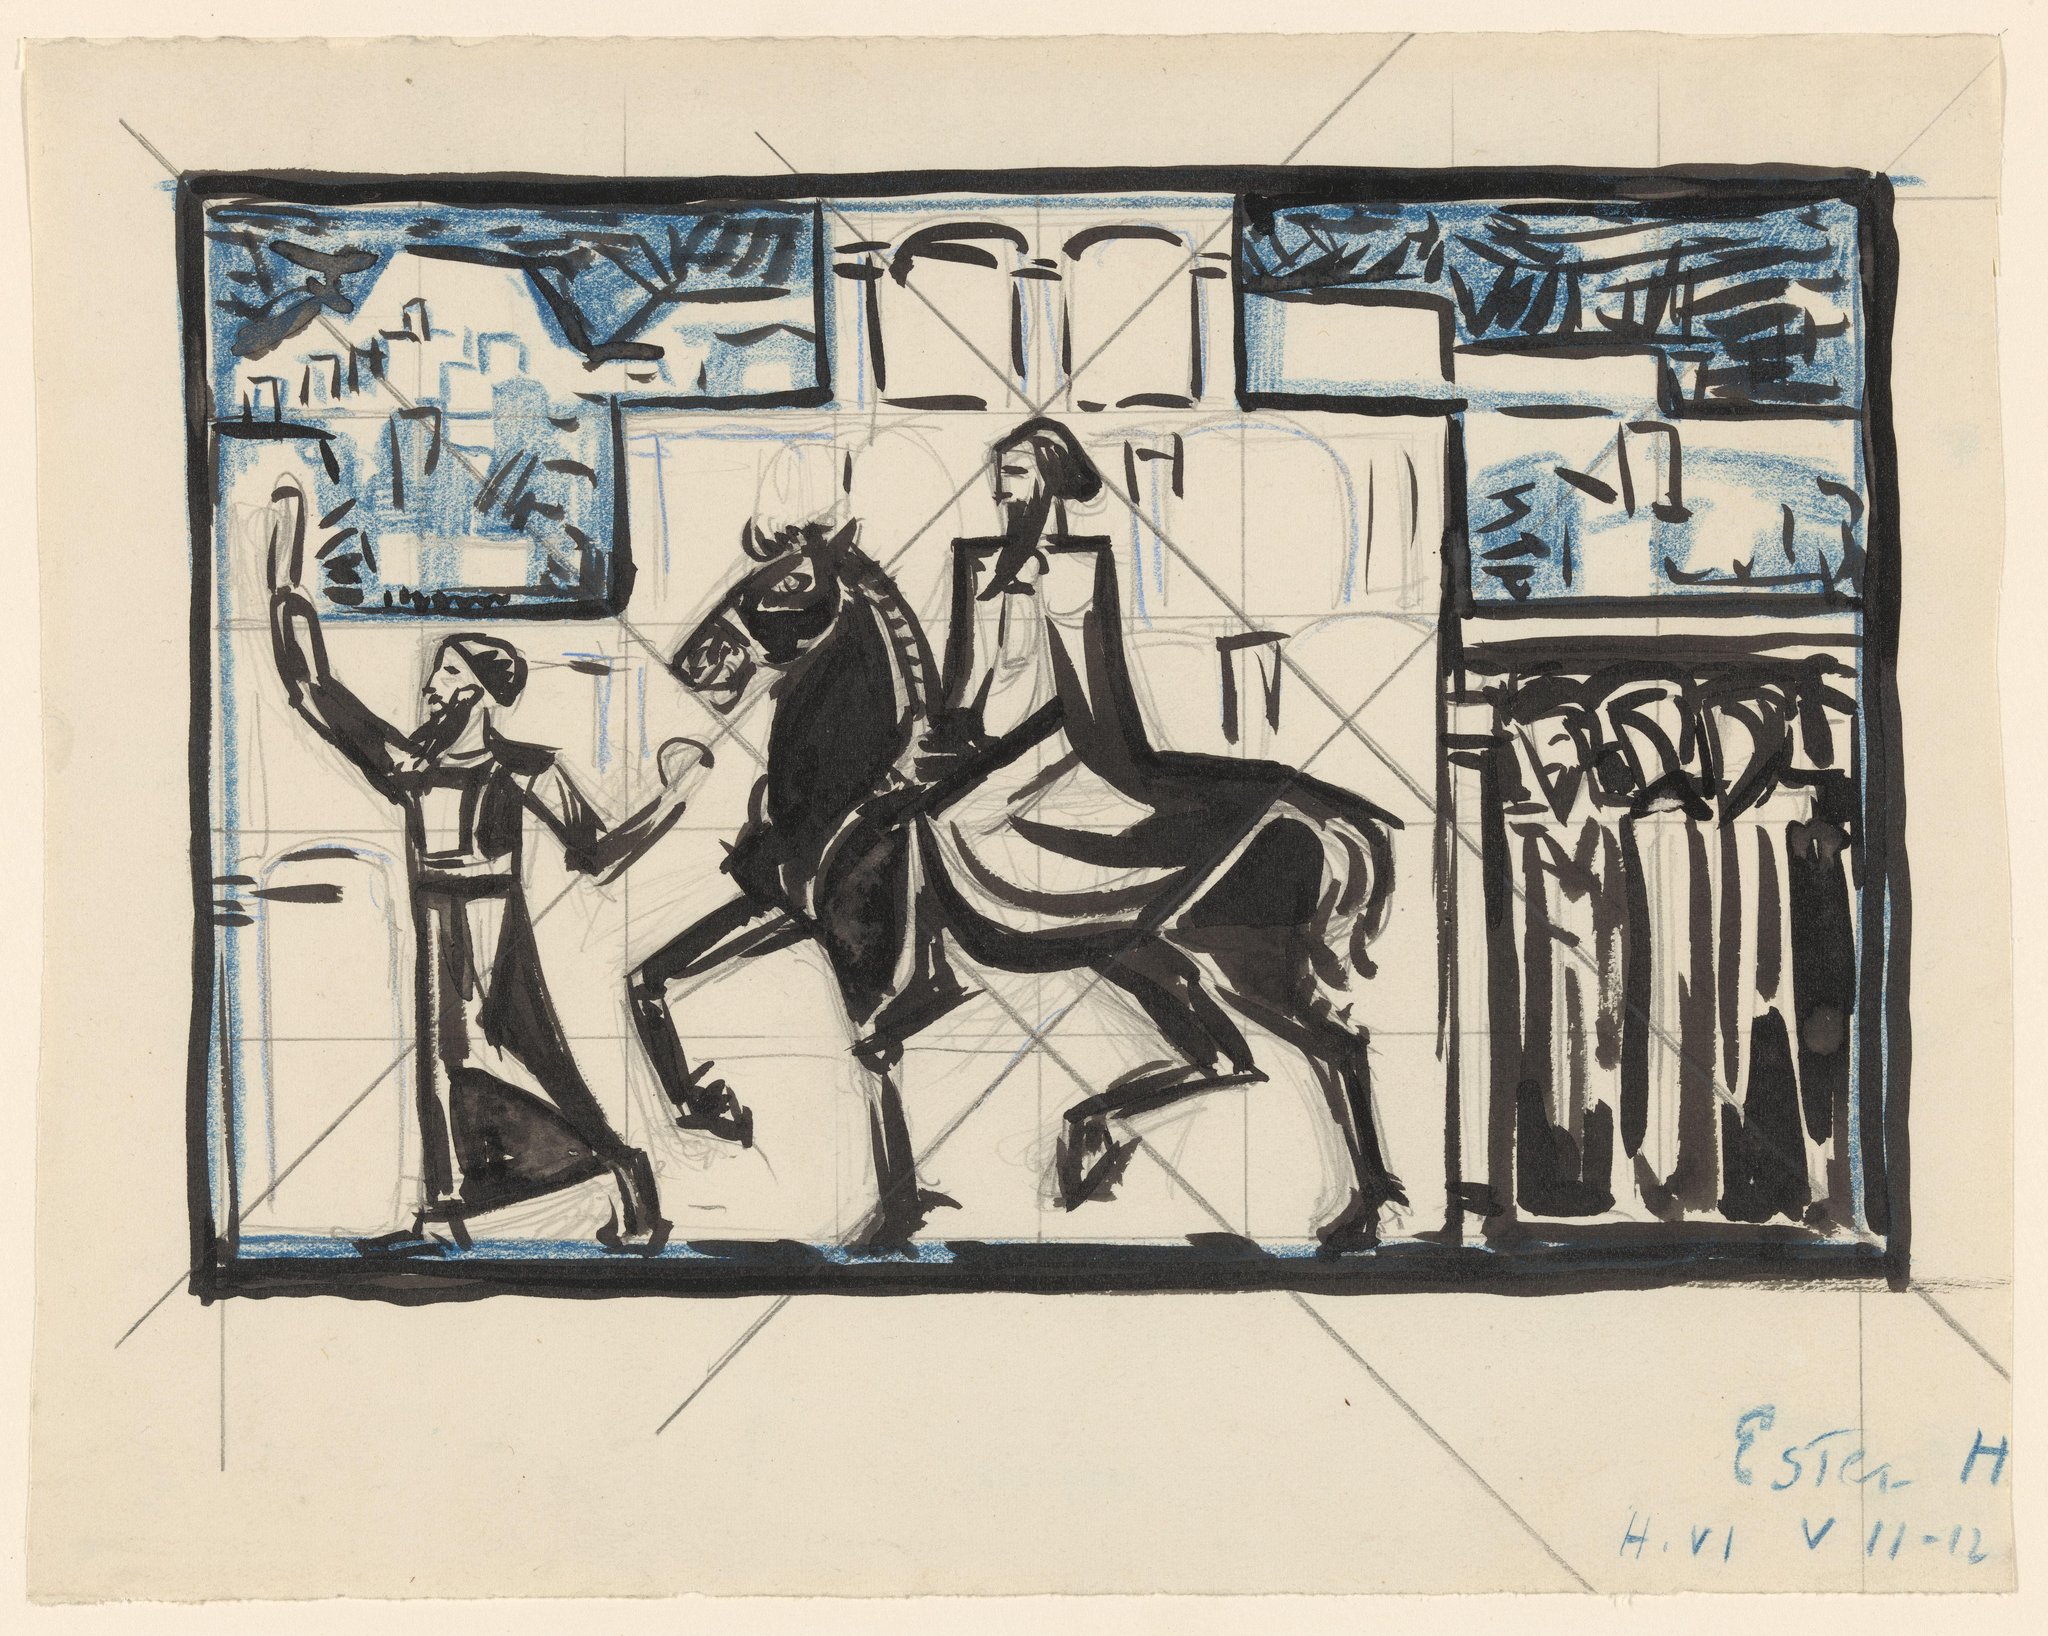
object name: drawing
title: Triomf van Mordechai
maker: richard nicolaüs roland holst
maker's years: 1868-1938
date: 1878-1938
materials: paper, pencil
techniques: brush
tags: mordecai's triumph: mordecai, mounted on the king's horse, is led through the city by haman (esther and ahasuerus may be looking on from the palace)